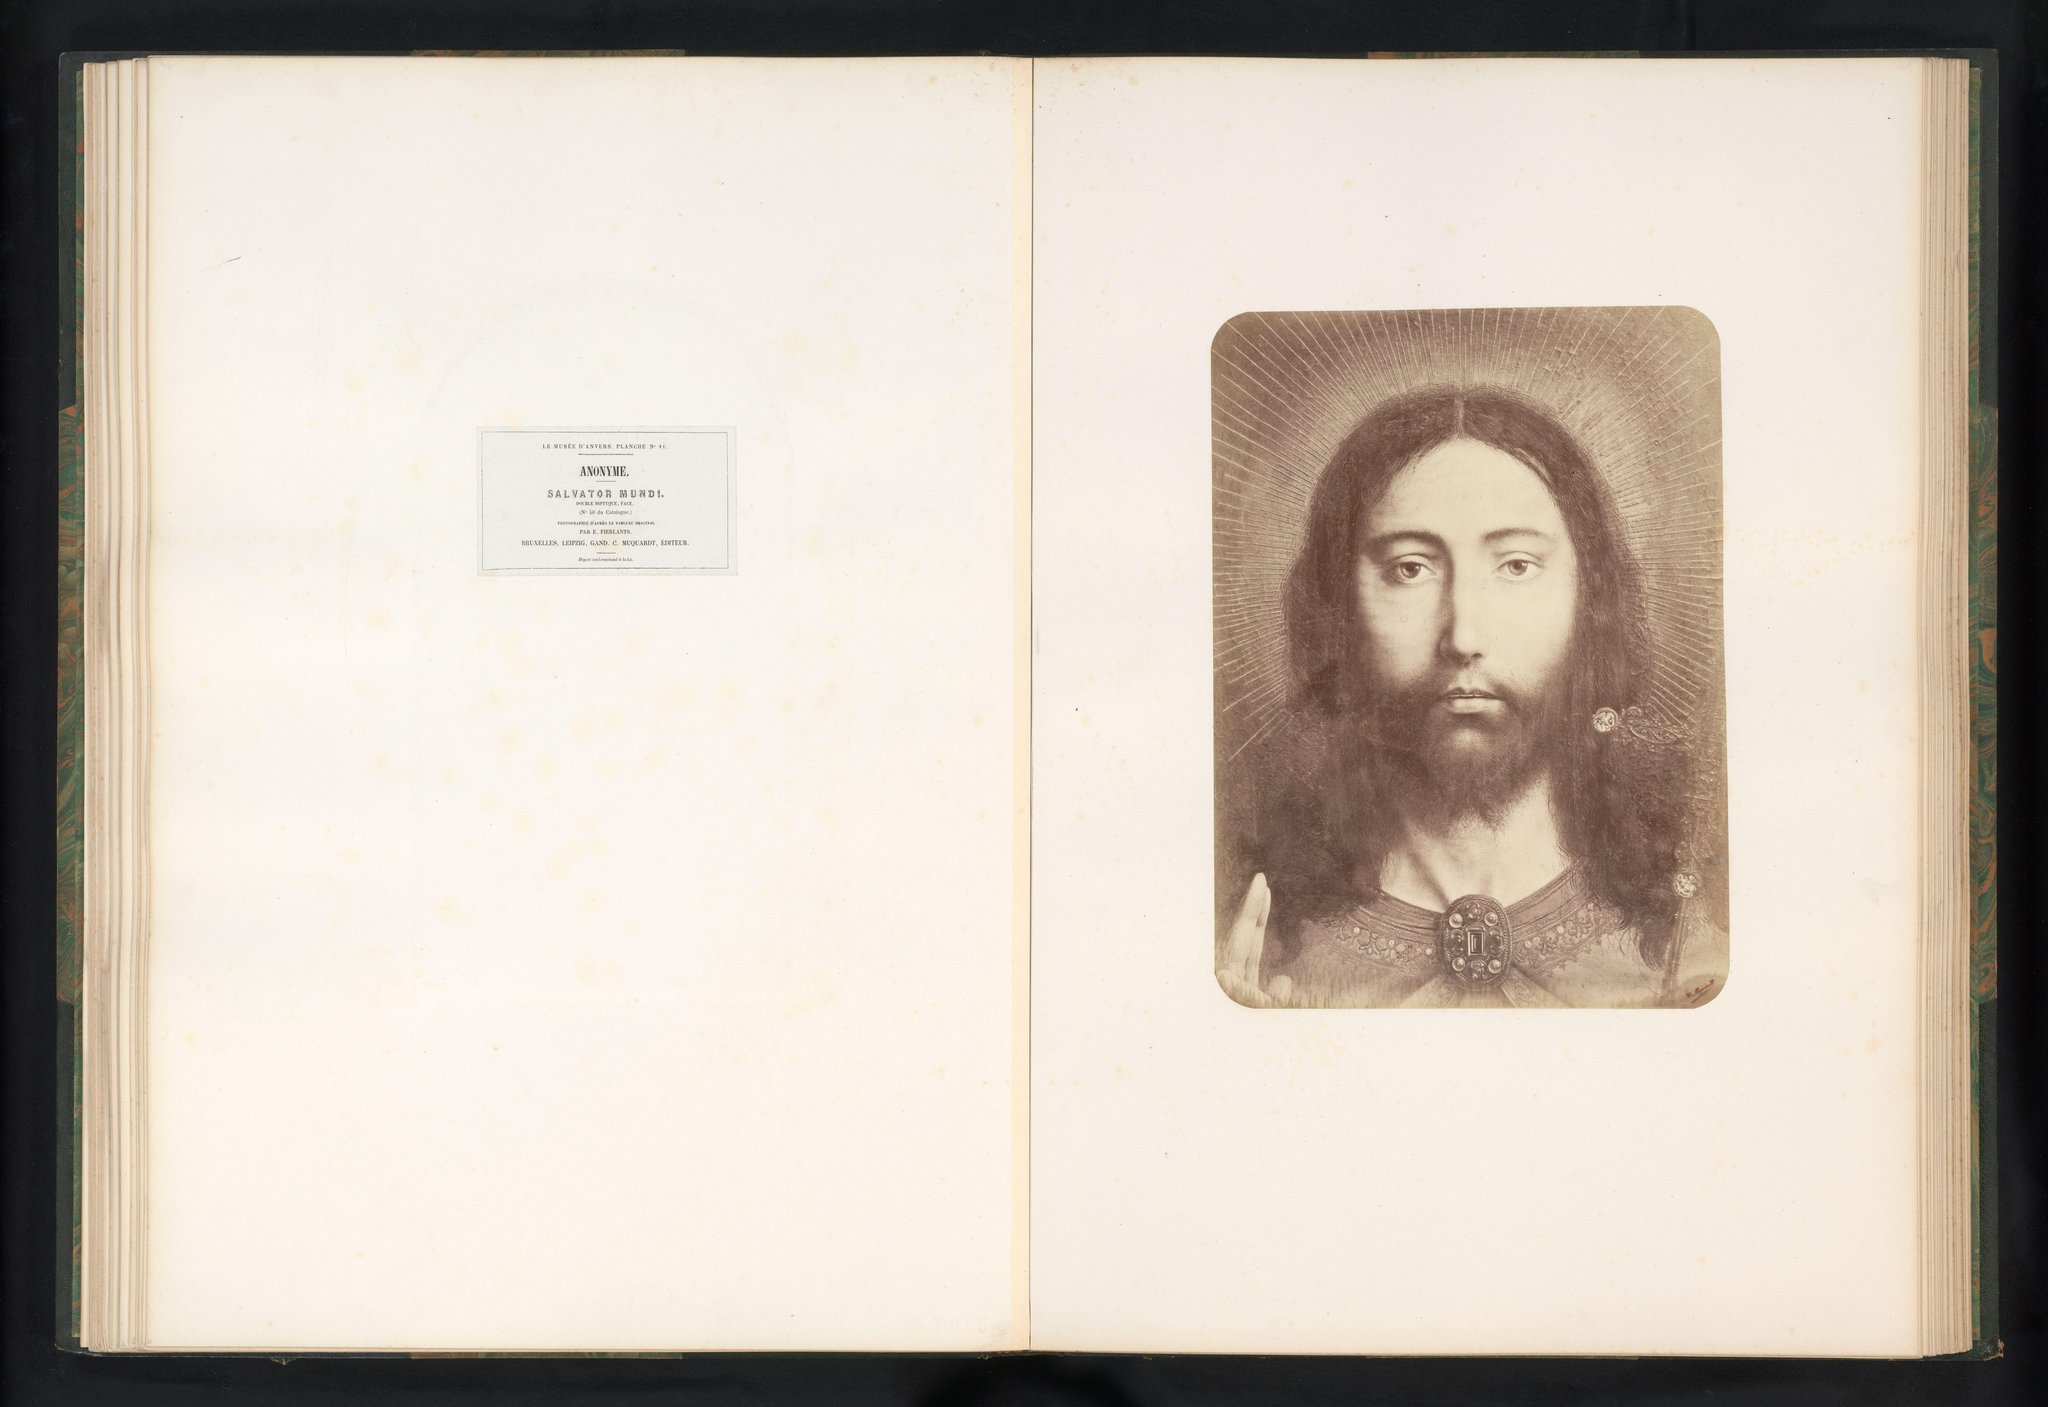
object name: page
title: Fotoreproductie van Christus als Salvator Mundi door Quinten Massijs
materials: photographic support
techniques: albumen print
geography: brussels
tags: 'salvator mundi', making a blessing gesture; an orb in his hand or at his feet